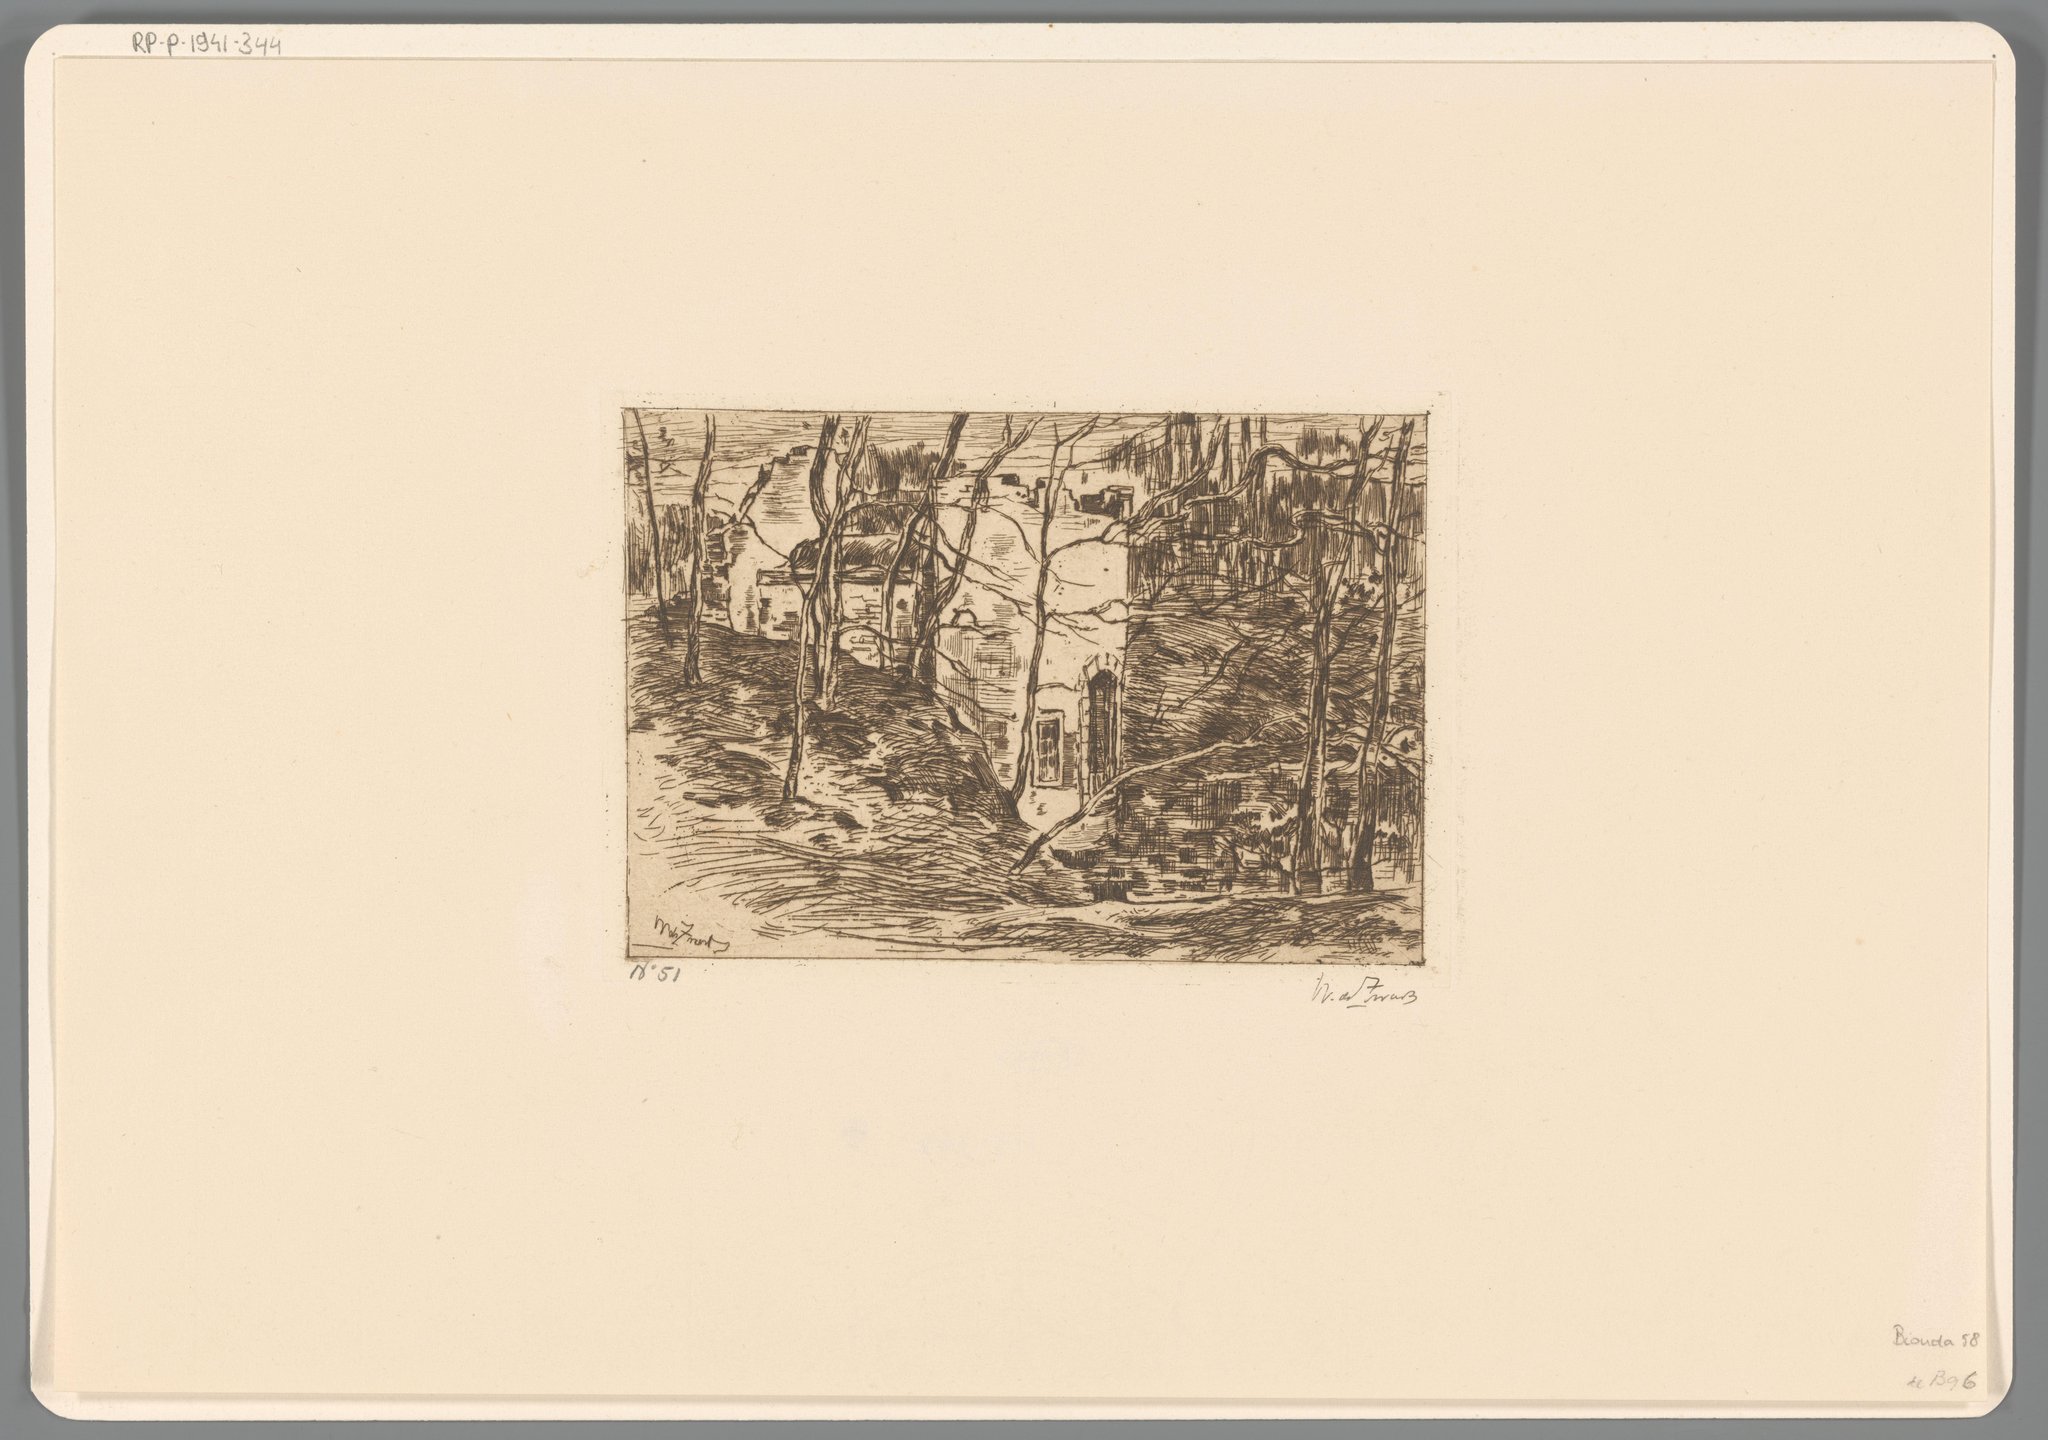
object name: print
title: Ruïne, vijver rechts (Lage Vuursche)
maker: willem de zwart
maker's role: draughtsman, painter, print maker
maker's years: 1862-1931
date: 1896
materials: paper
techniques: etching, intaglio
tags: landscape with ruins, forest, wood, pond, pool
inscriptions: collector's mark: Lugt 2228, collector's mark: Lugt 2760